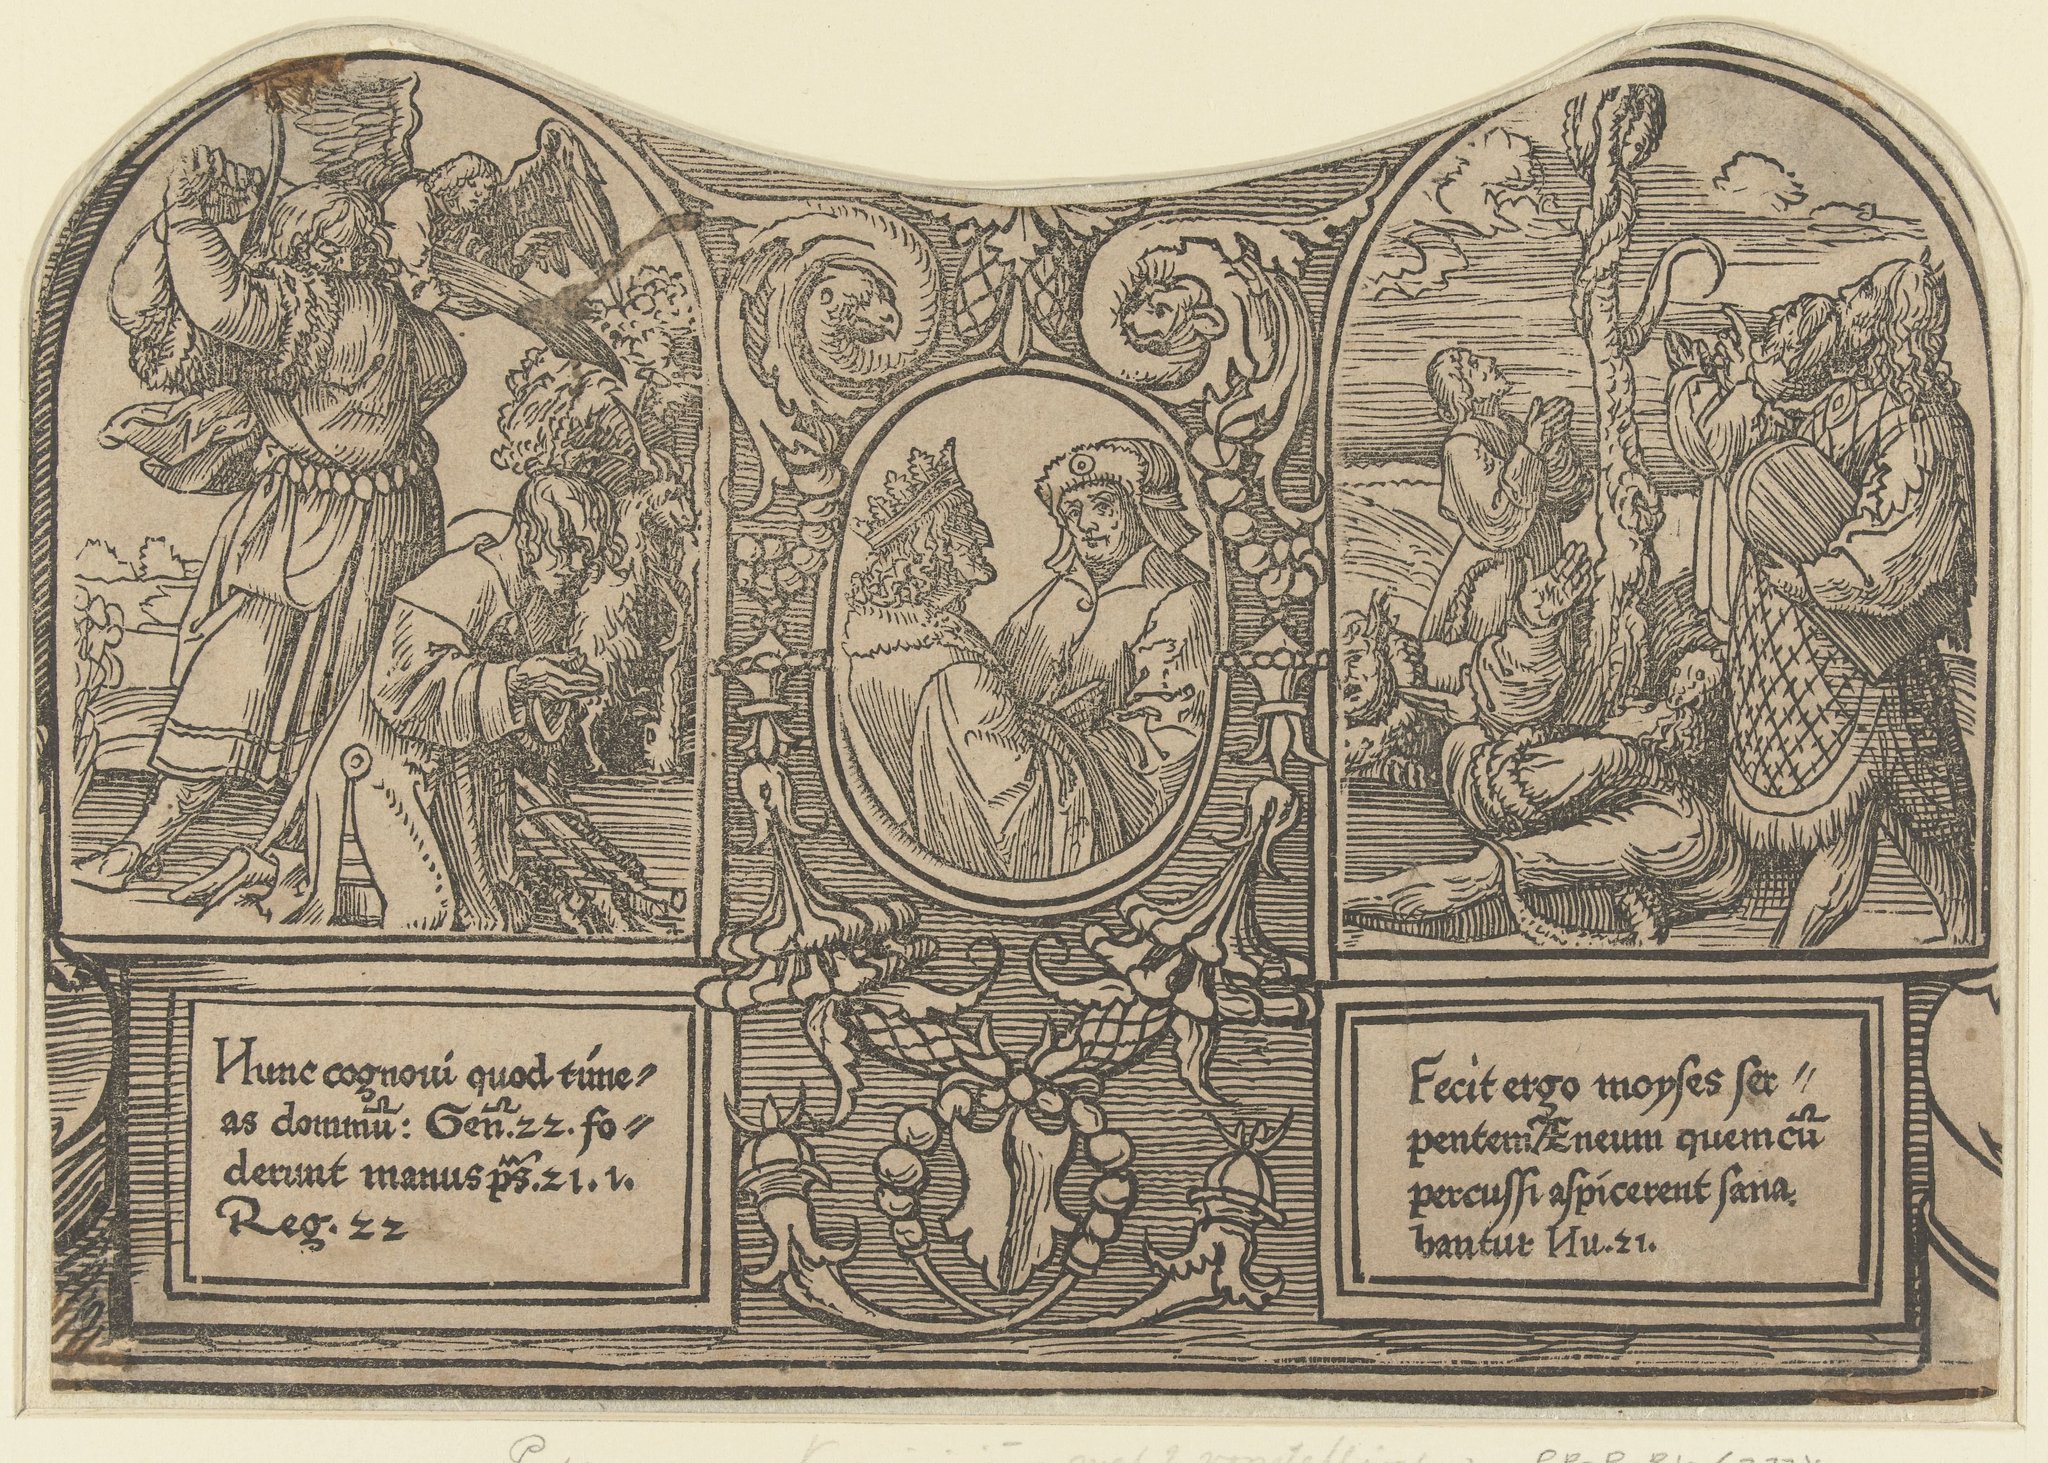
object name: print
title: Het offer van Abraham en de koperen slang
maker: jacob cornelisz van oostsanen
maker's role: draughtsman, painter, print maker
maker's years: 1475-1533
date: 1517-1533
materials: paper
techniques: woodcut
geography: low countries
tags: a serpent of brass is made and is set on a pole, when abraham has his hand raised to kill isaac, god or the hand of god restrains abraham's hand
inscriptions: collector's mark: Lugt 240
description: Onderste deel van een blad, uit serie van twaalf prenten. Gedrukt van meerdere blokken. Twee scènes uit het oude testament, prefiguraties van de kruisiging: links Abraham die Isaak offert en wordt tegengehouden door engel, met verwijzingen naar bijbelteksten er onder, rechts Mozes en de oprichting van de koperen slang, met verwijzingen naar bijbelsteksten er onder. In het midden twee profeten.